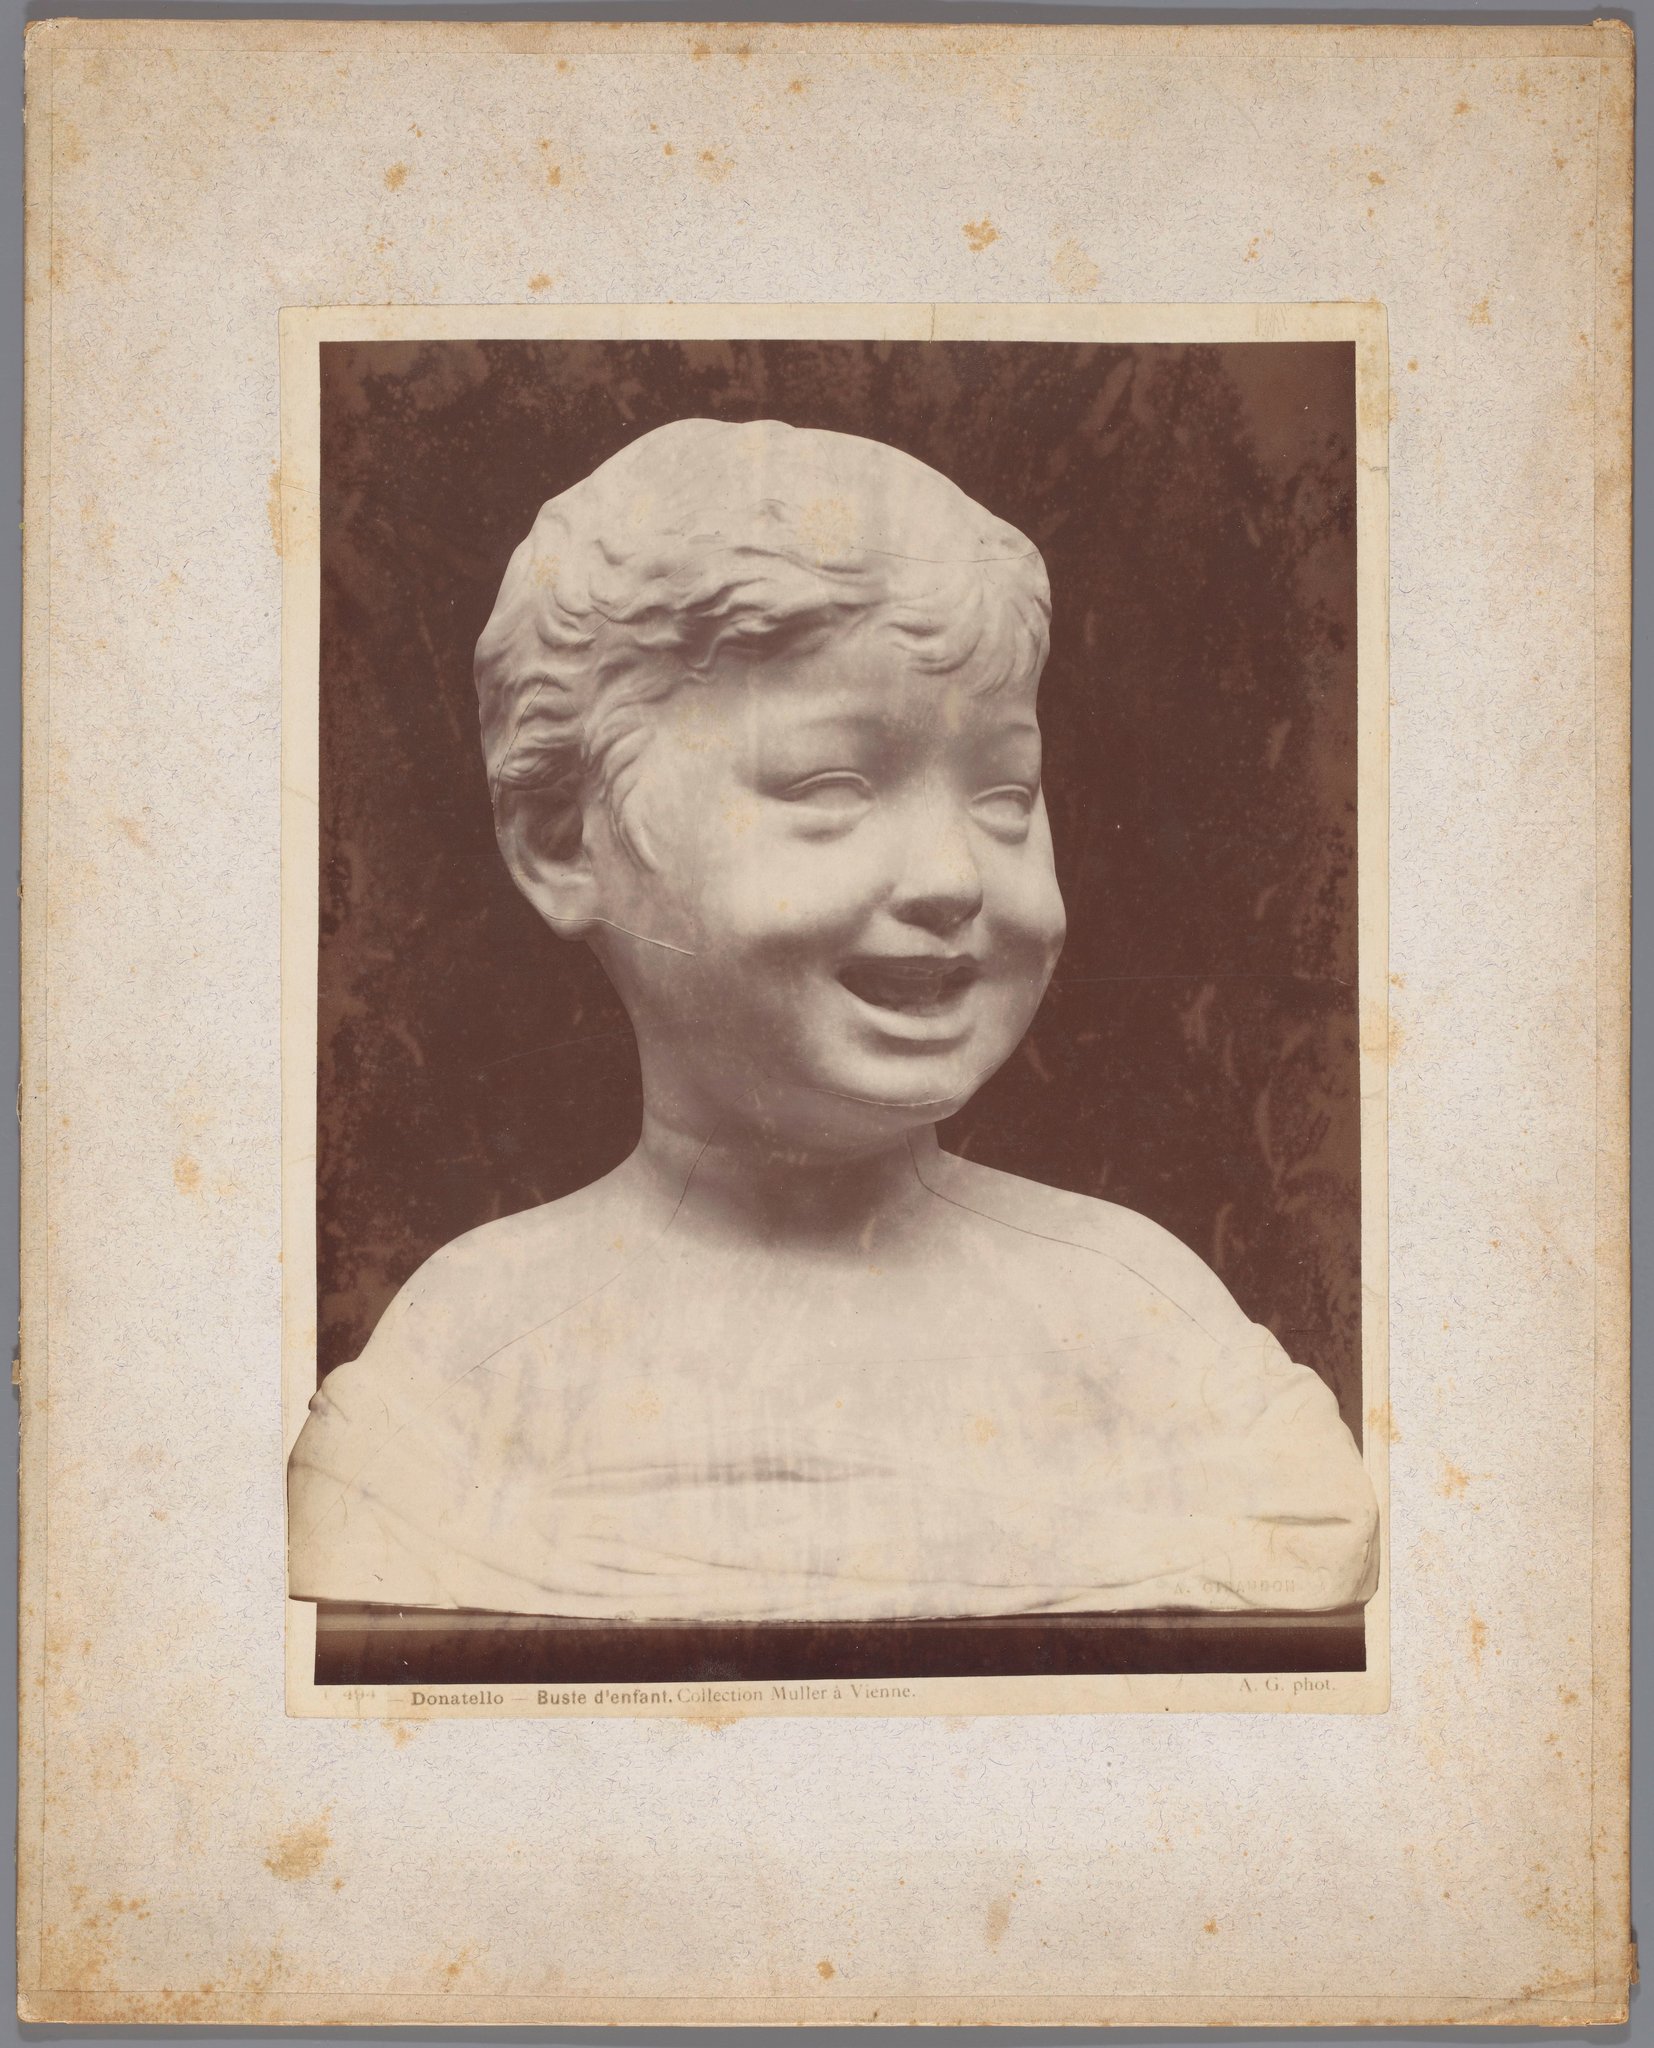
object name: photograph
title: Donatello - Buste d'enfant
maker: adolphe giraudon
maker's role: publisher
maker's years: 1849-1929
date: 1850-1900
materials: cardboard, photographic support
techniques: albumen print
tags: piece of sculpture, reproduction of a piece of sculpture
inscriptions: number: ‘T 494’, collector's mark: ‘Rijks-normaalschool voor teekenonderwijzers amsterdam’, inscription: ‘Collection Muller à Vienne. A.G. phot.’, workshop stamp: ‘A. Giraudon/ Éditeur/ 15. R. Bonaparte. Paris’